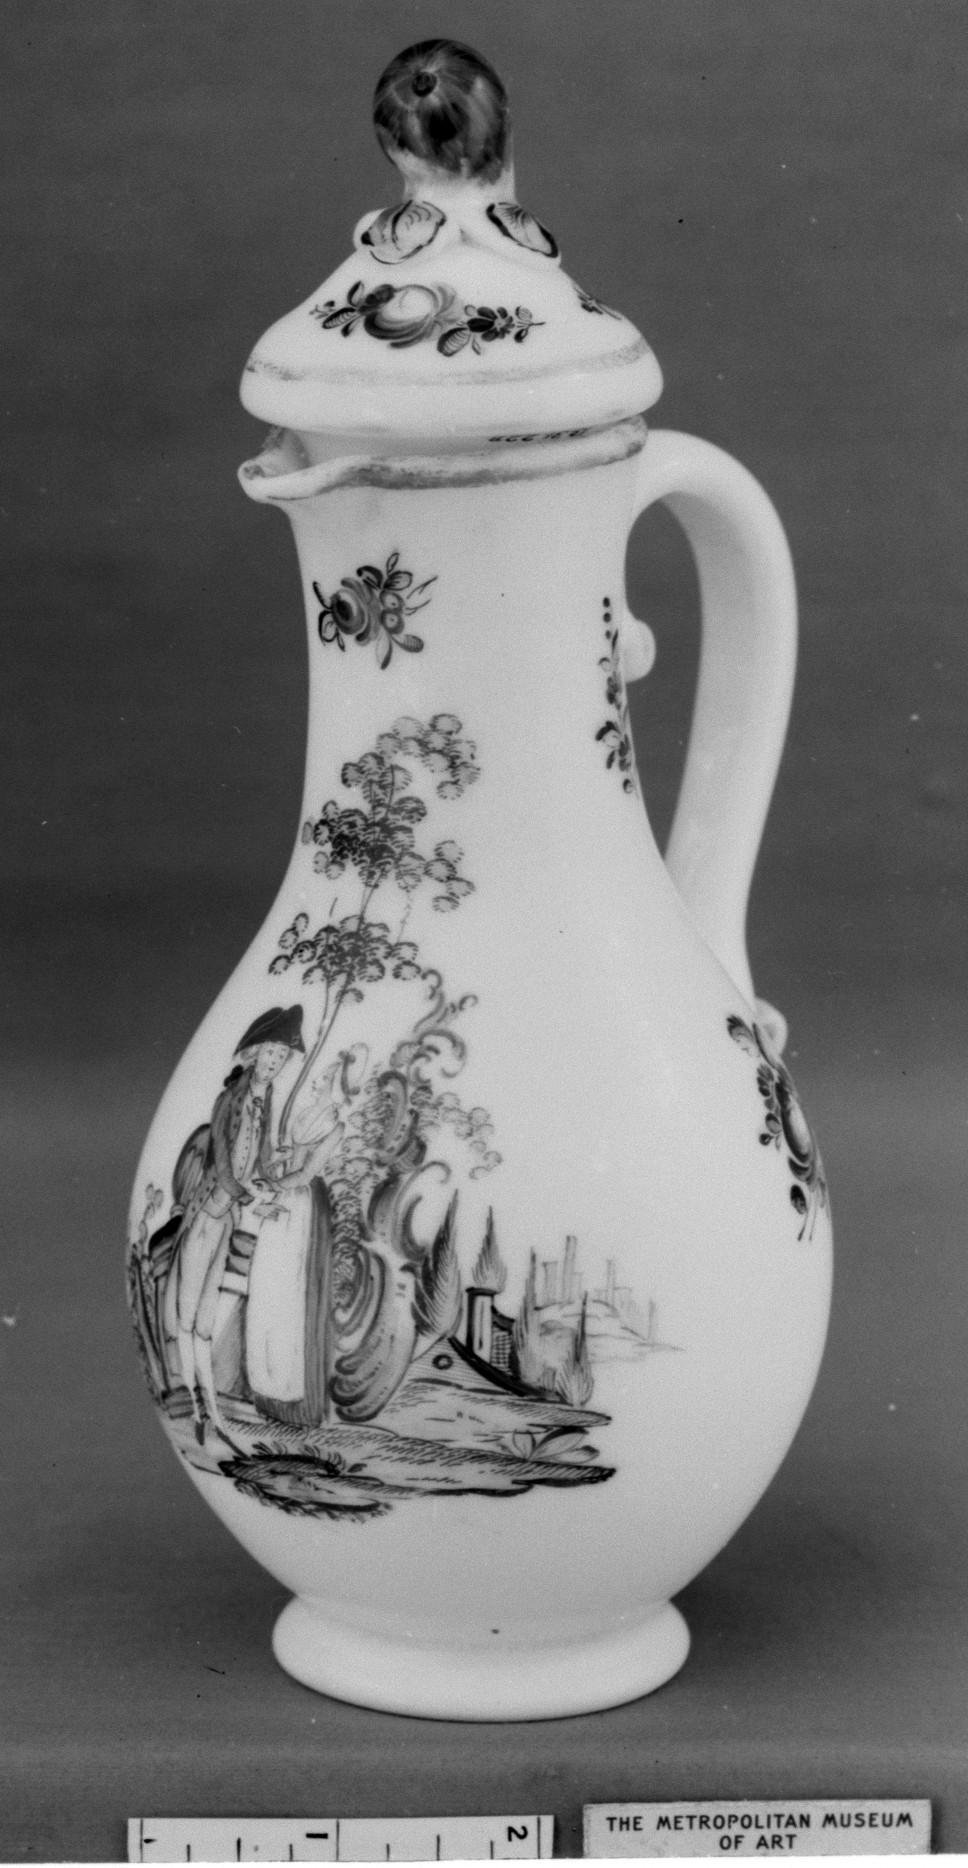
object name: jug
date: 1770-1790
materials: glass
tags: men,women,trees